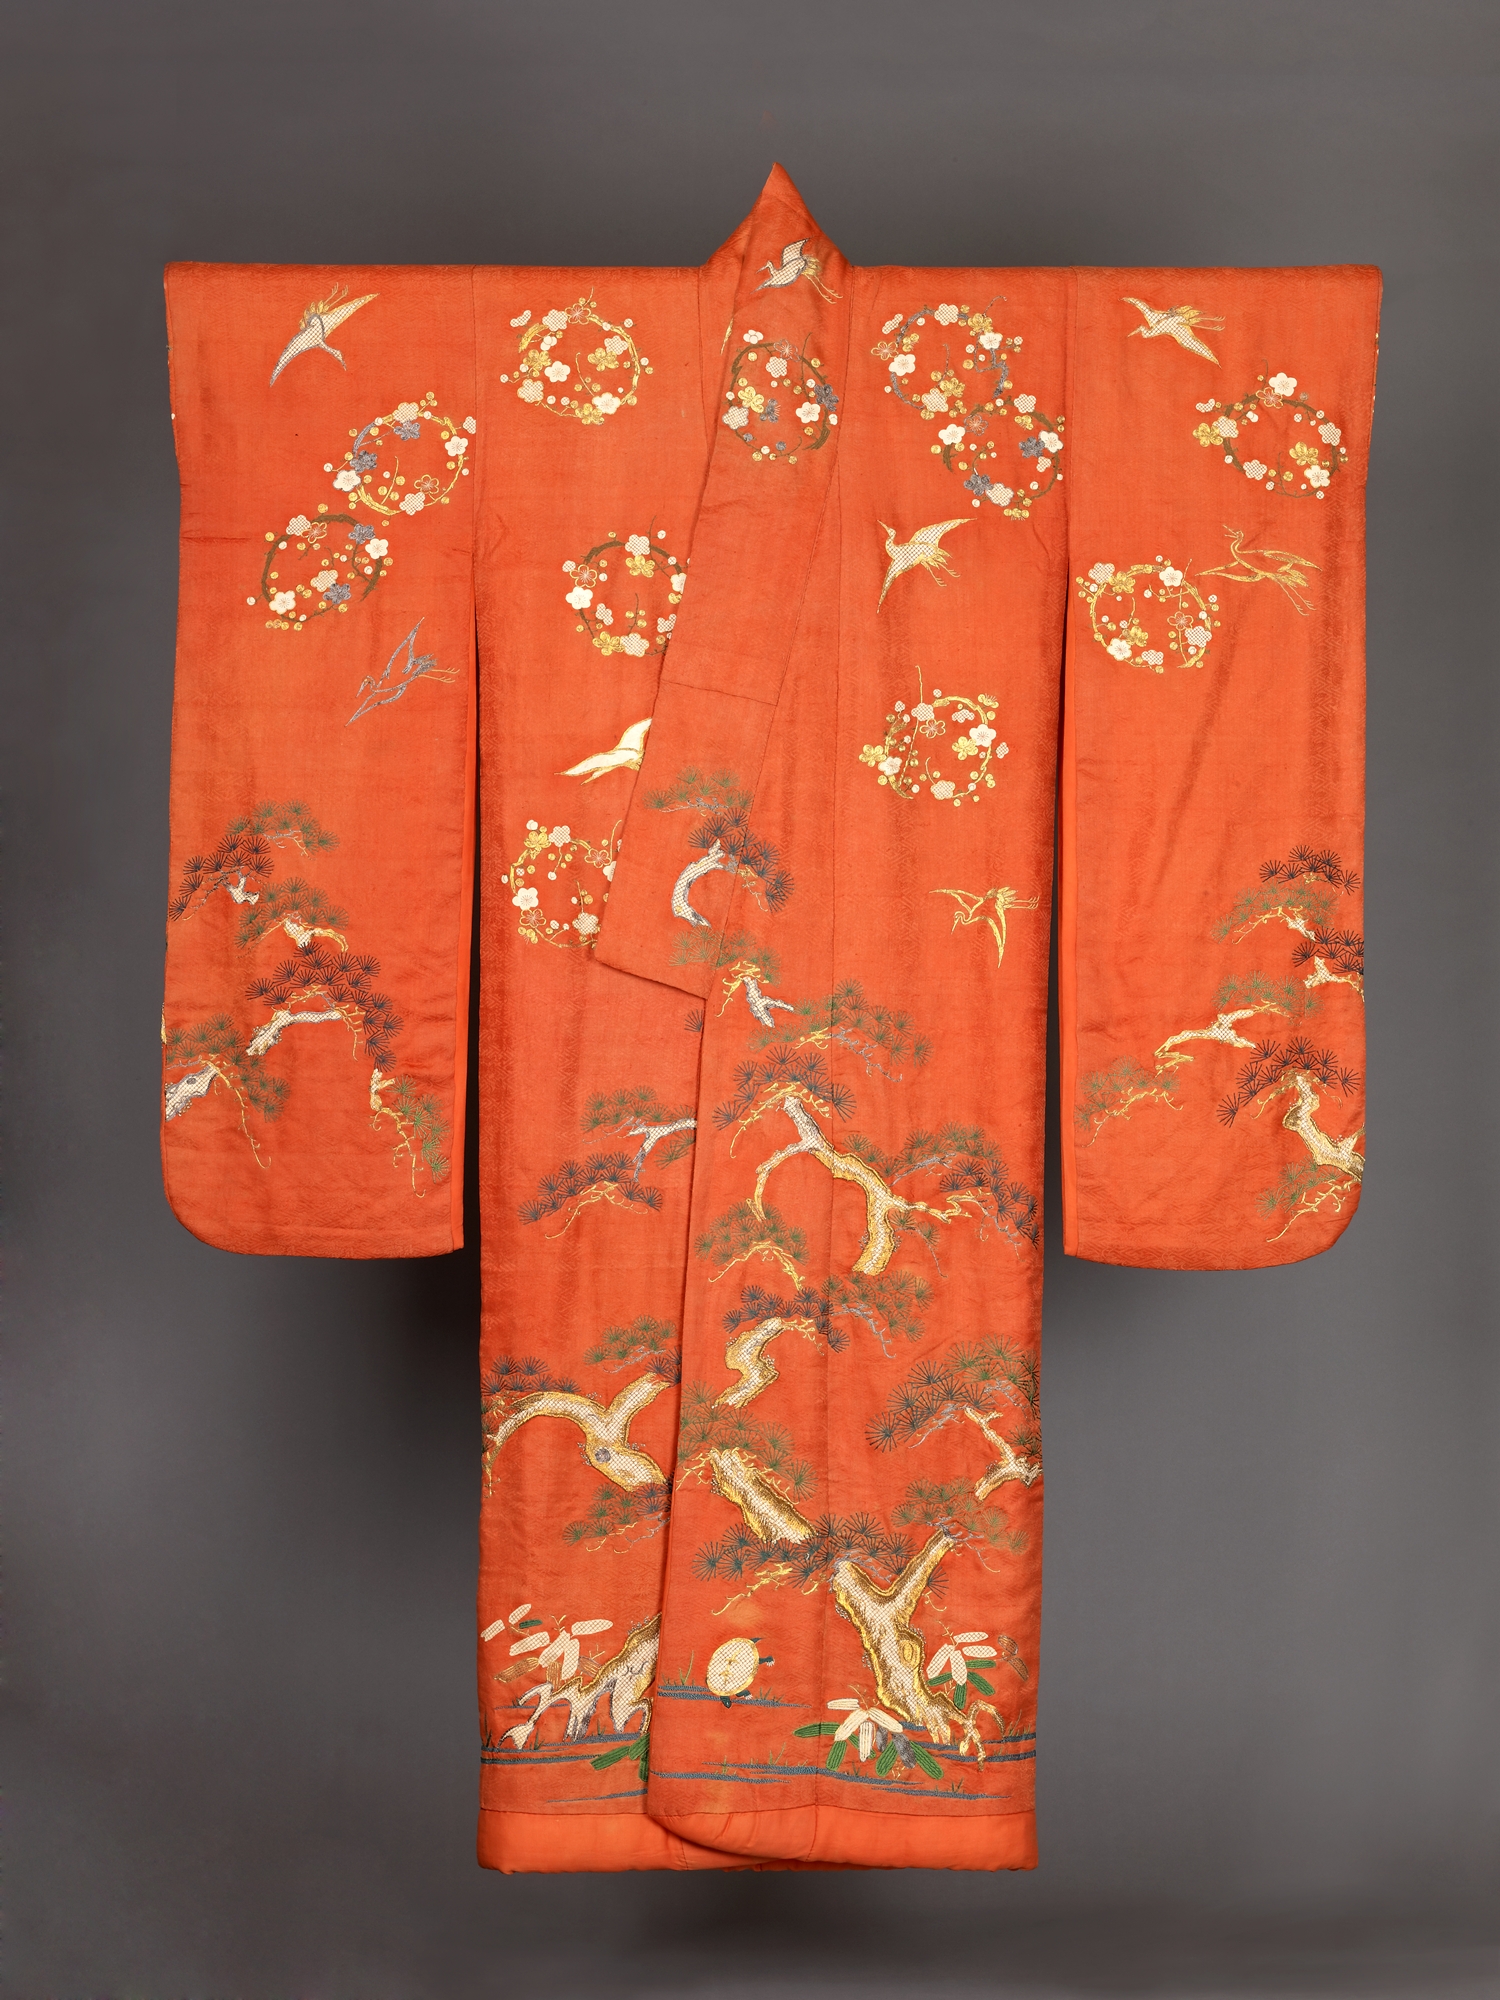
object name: furisode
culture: japanese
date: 1801-1900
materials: gilt, metal thread, textile, silk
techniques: dyeing, embroidery, satin weave, silvered, stitching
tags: cranes,trees